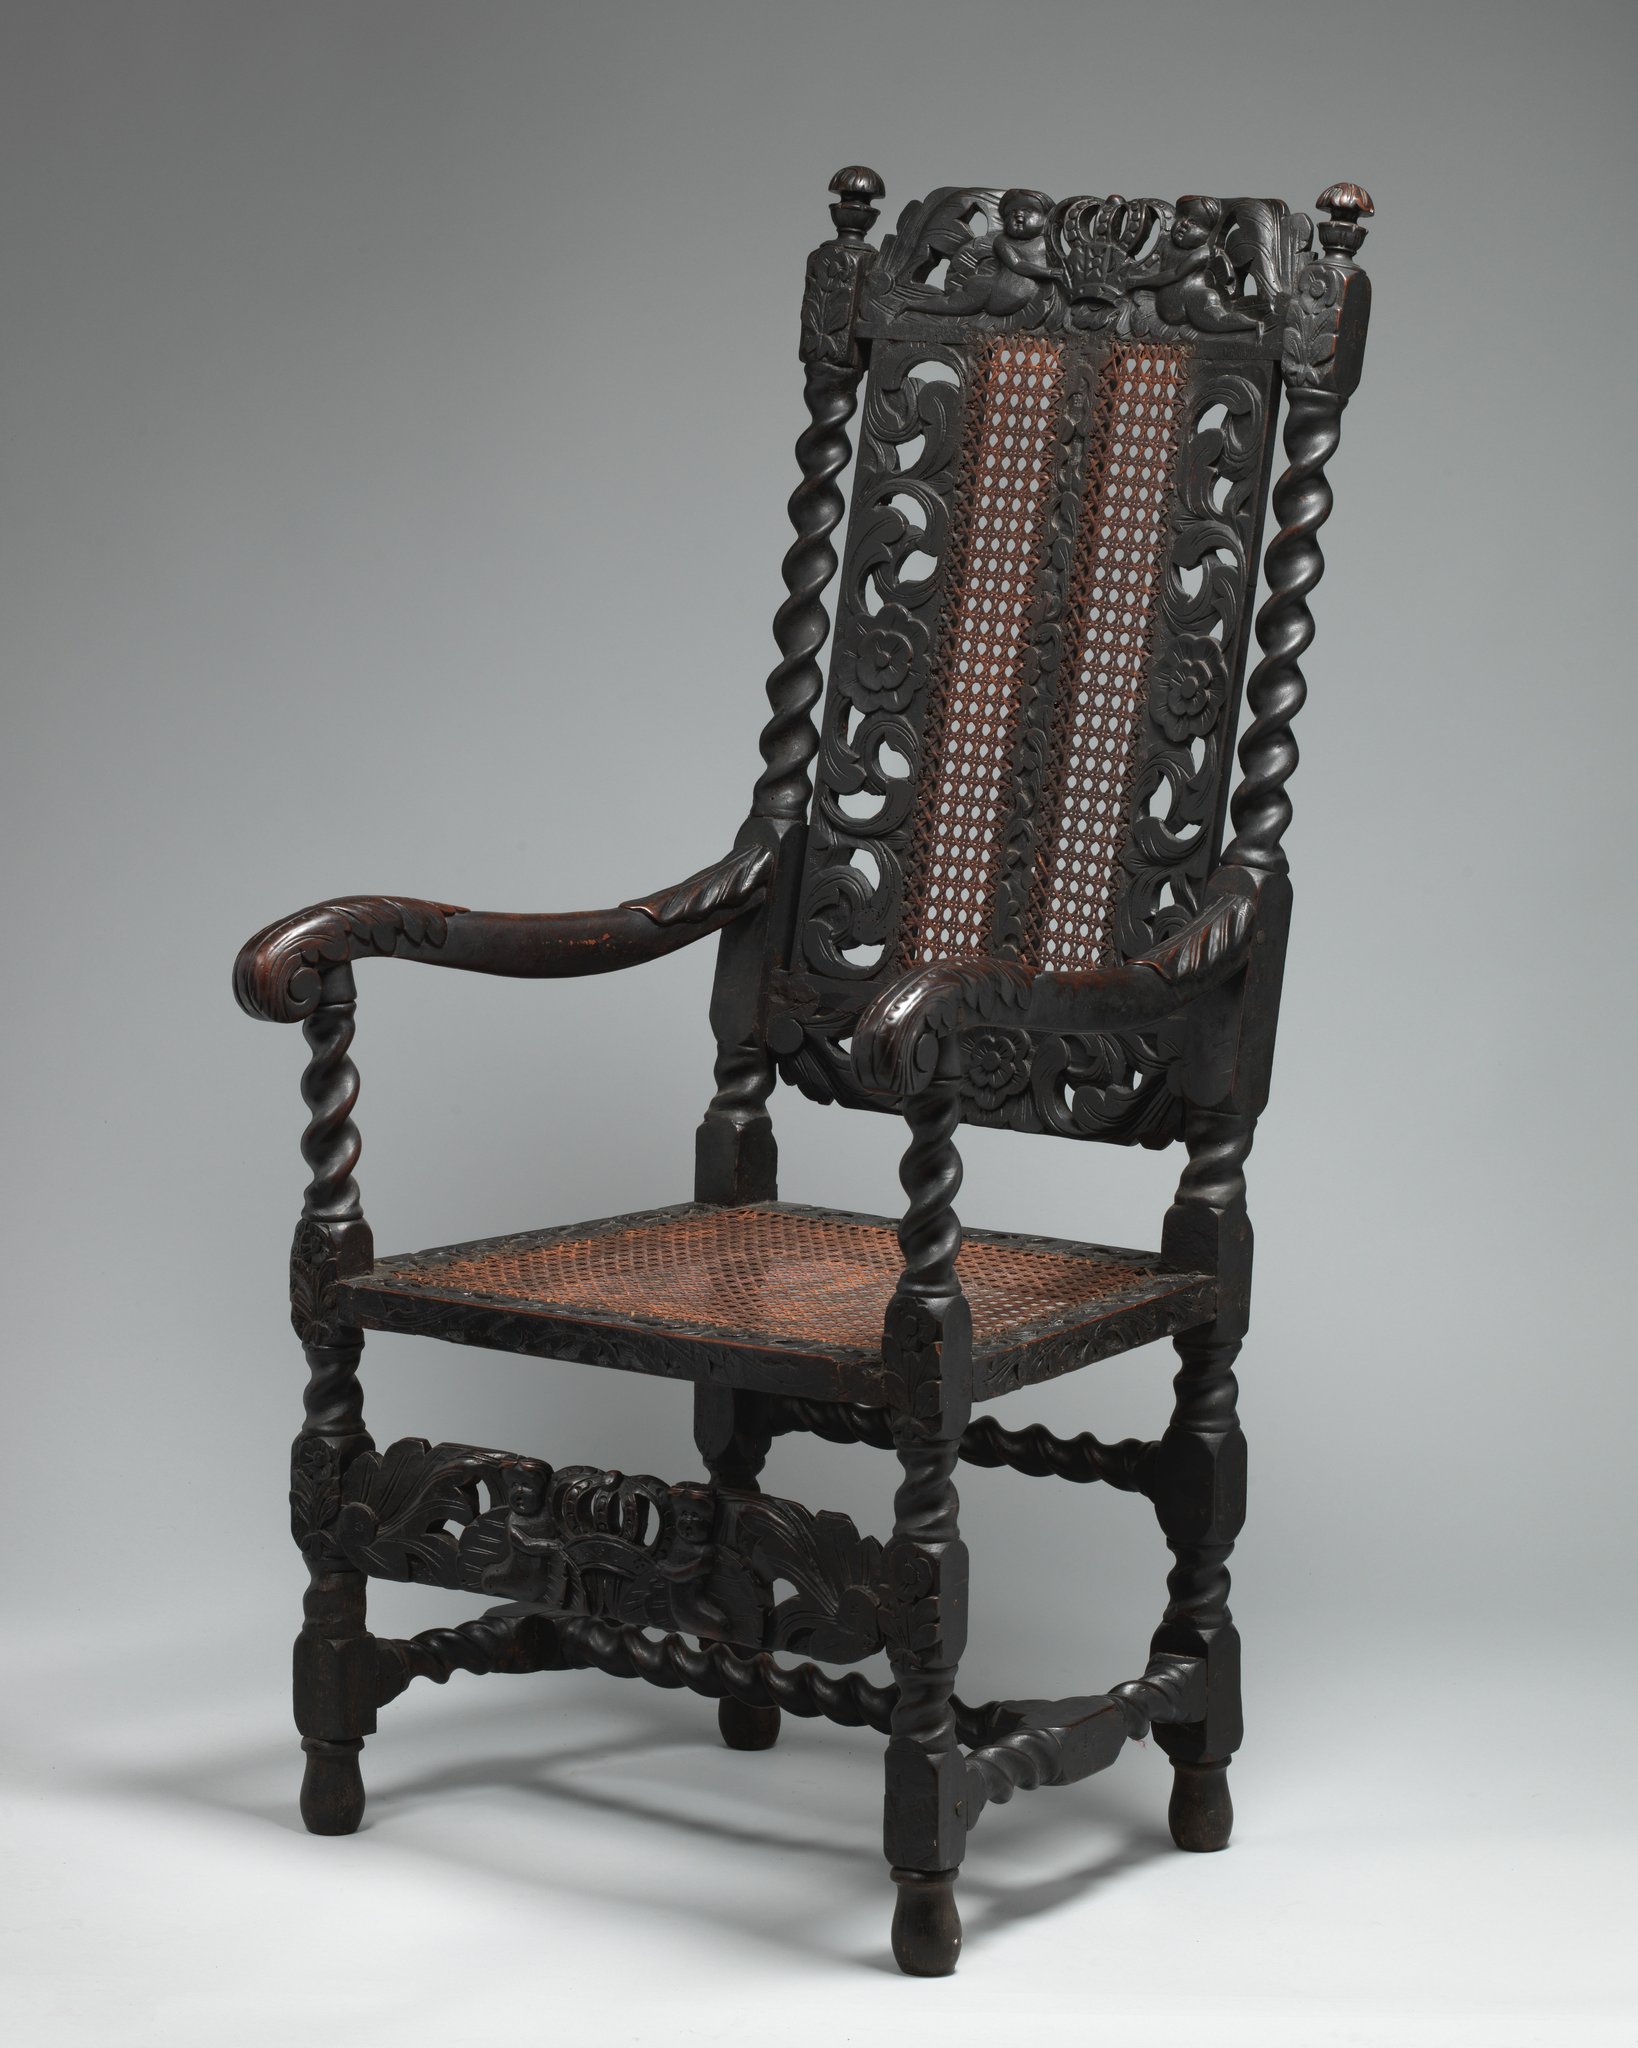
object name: armchair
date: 1660-1685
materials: wood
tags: infants,flowers